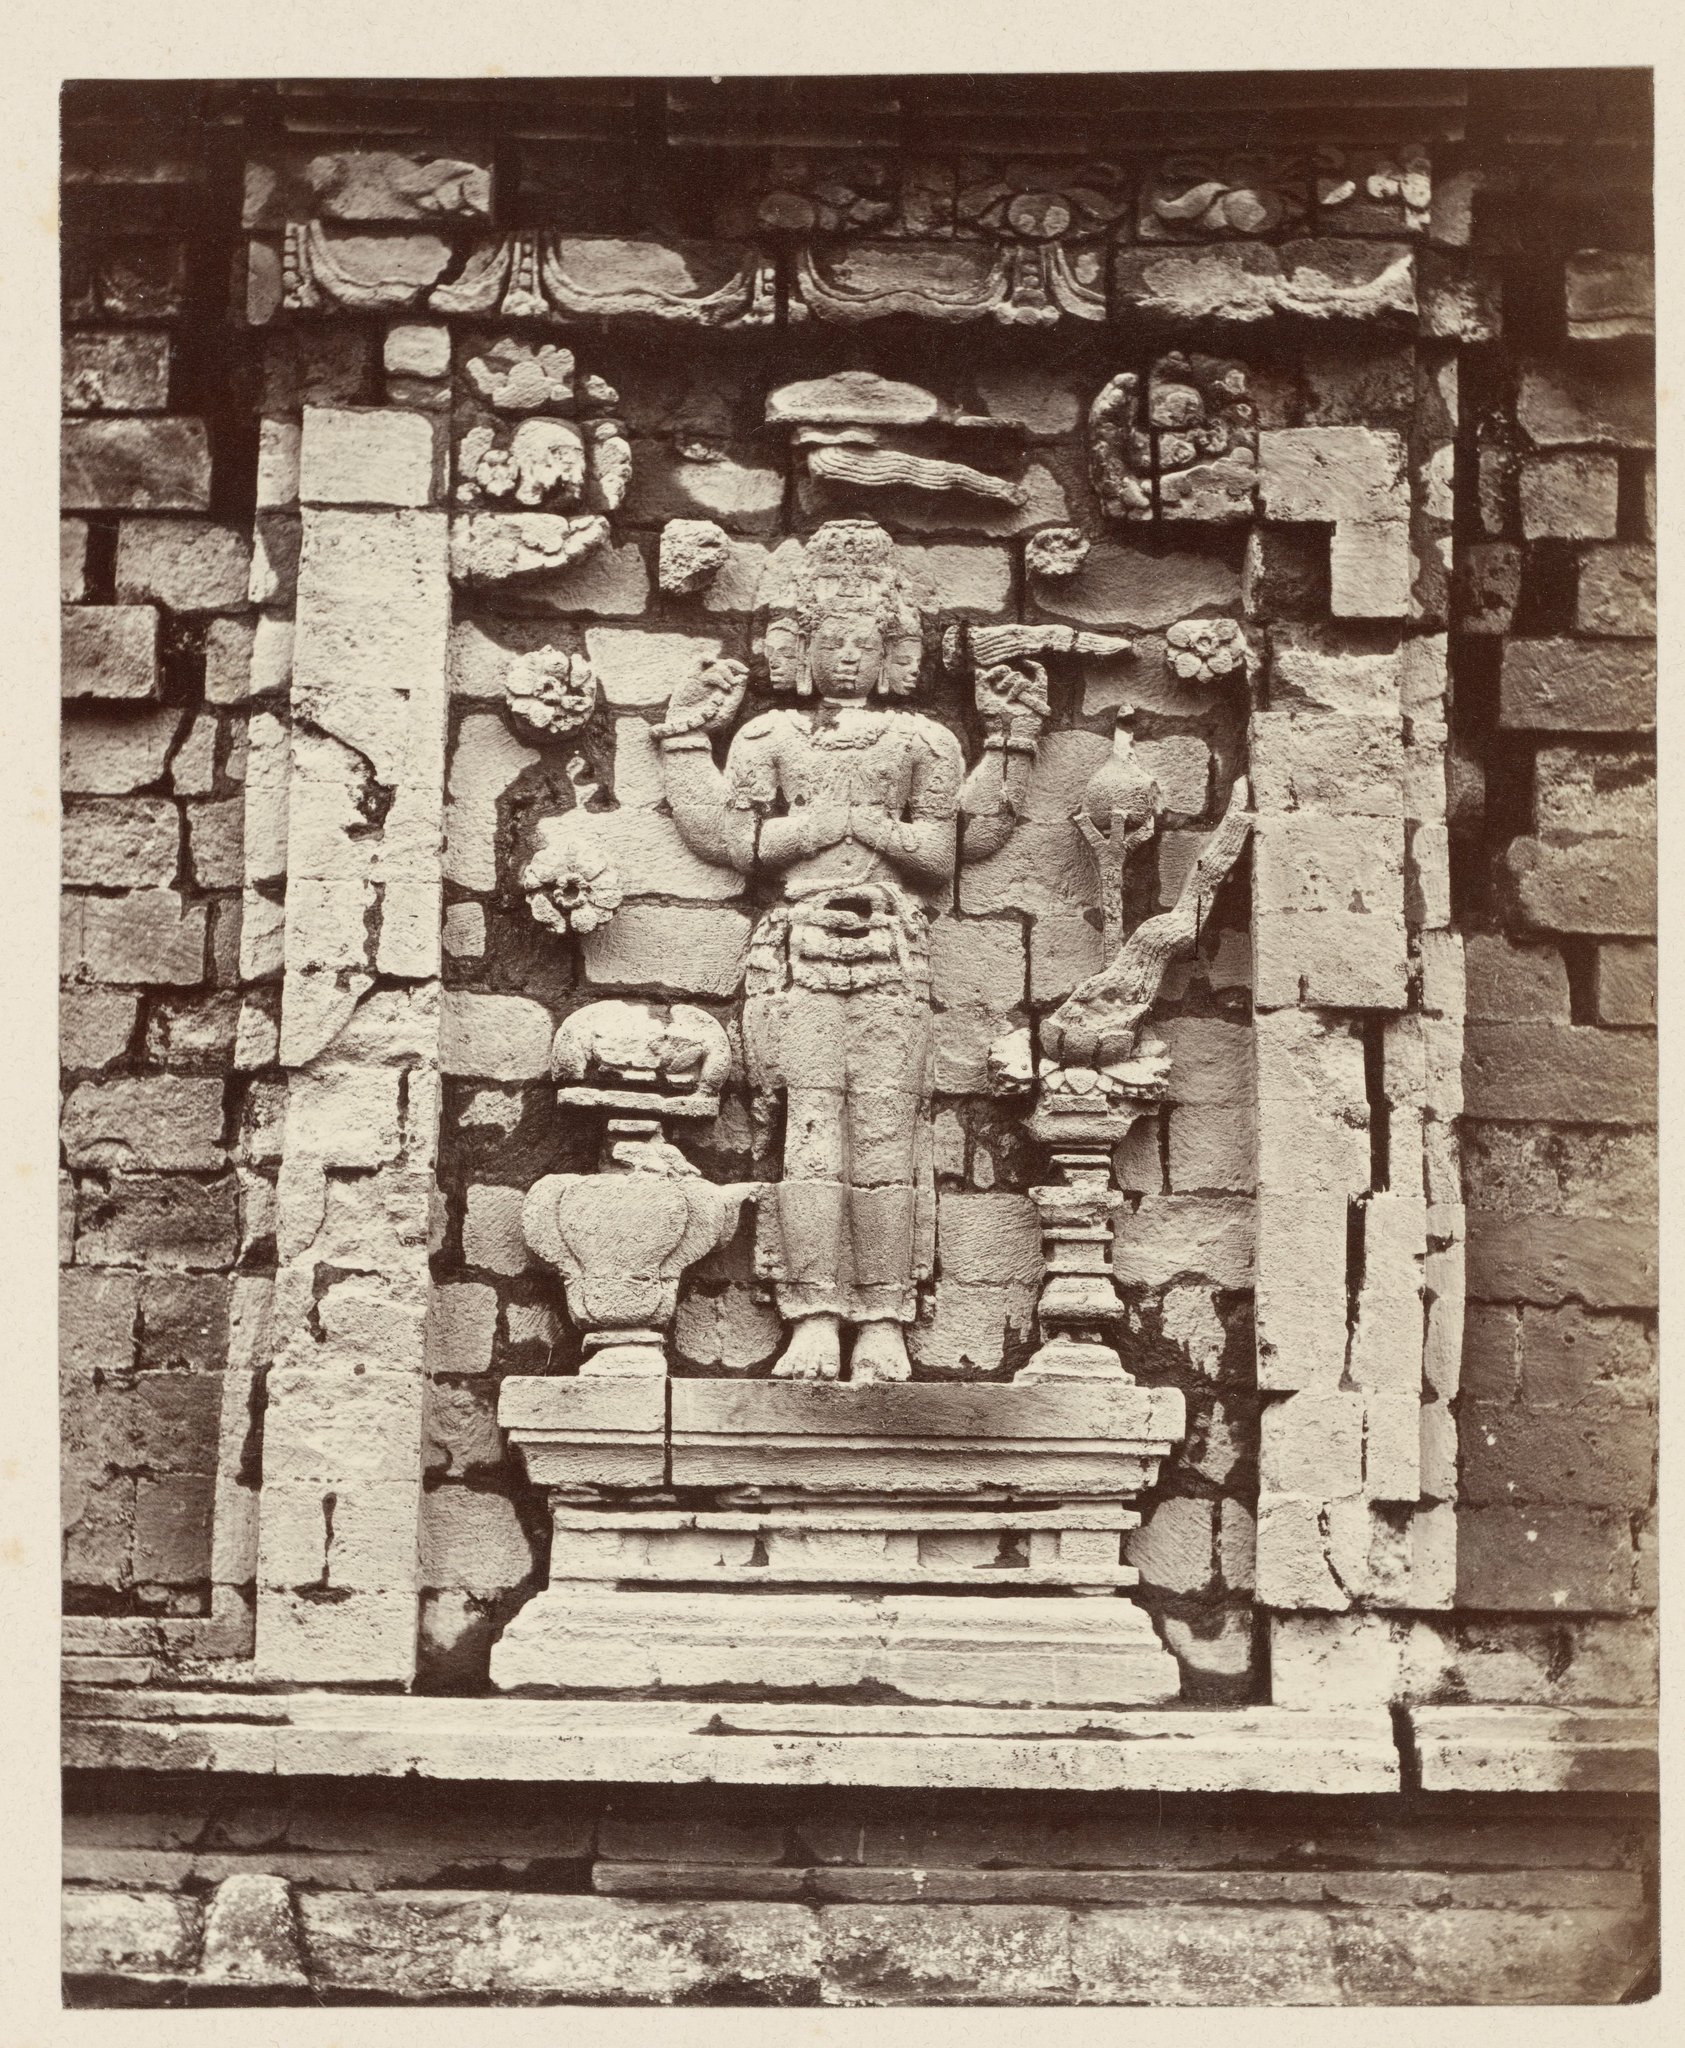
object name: photograph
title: Candi Srikandi, details of the southern niche decorated with a four-armed Brahma. Dieng PLateau, Wonosobo District, Central Java province, 8th-9th century Indonesia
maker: isidore kinsbergen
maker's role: fotograaf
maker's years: 1821-1905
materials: cardboard, paper, photographic support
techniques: albumen print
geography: java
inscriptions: title: ‘Basrelief van den tempel (Brahma) Cat. no. 95 te Diëng-plateau (Residentie Bagelen)’, number: ‘42’